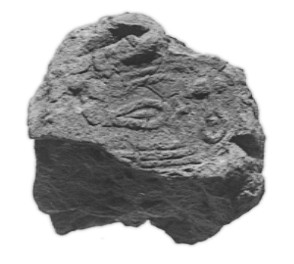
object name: sealing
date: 2030-1640 BCE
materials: clay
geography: egypt